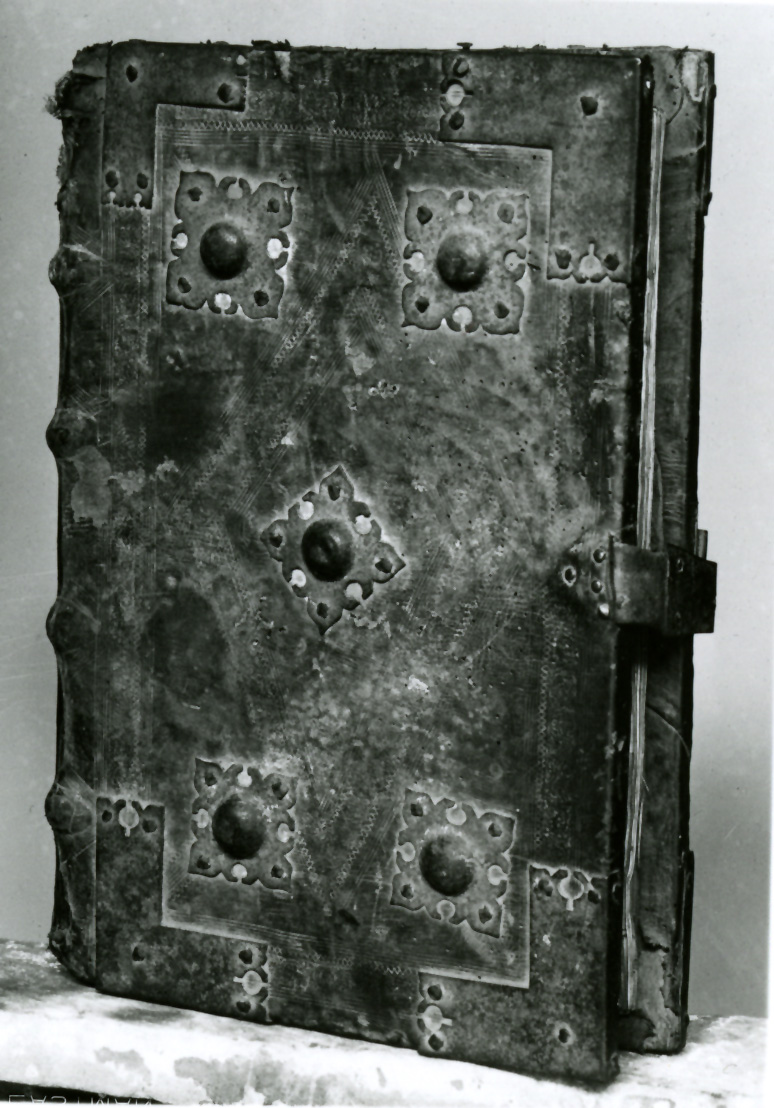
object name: antiphonary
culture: spanish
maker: manuel de boada guittierrez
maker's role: artist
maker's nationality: spanish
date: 1600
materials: leather, parchment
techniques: bookbinding